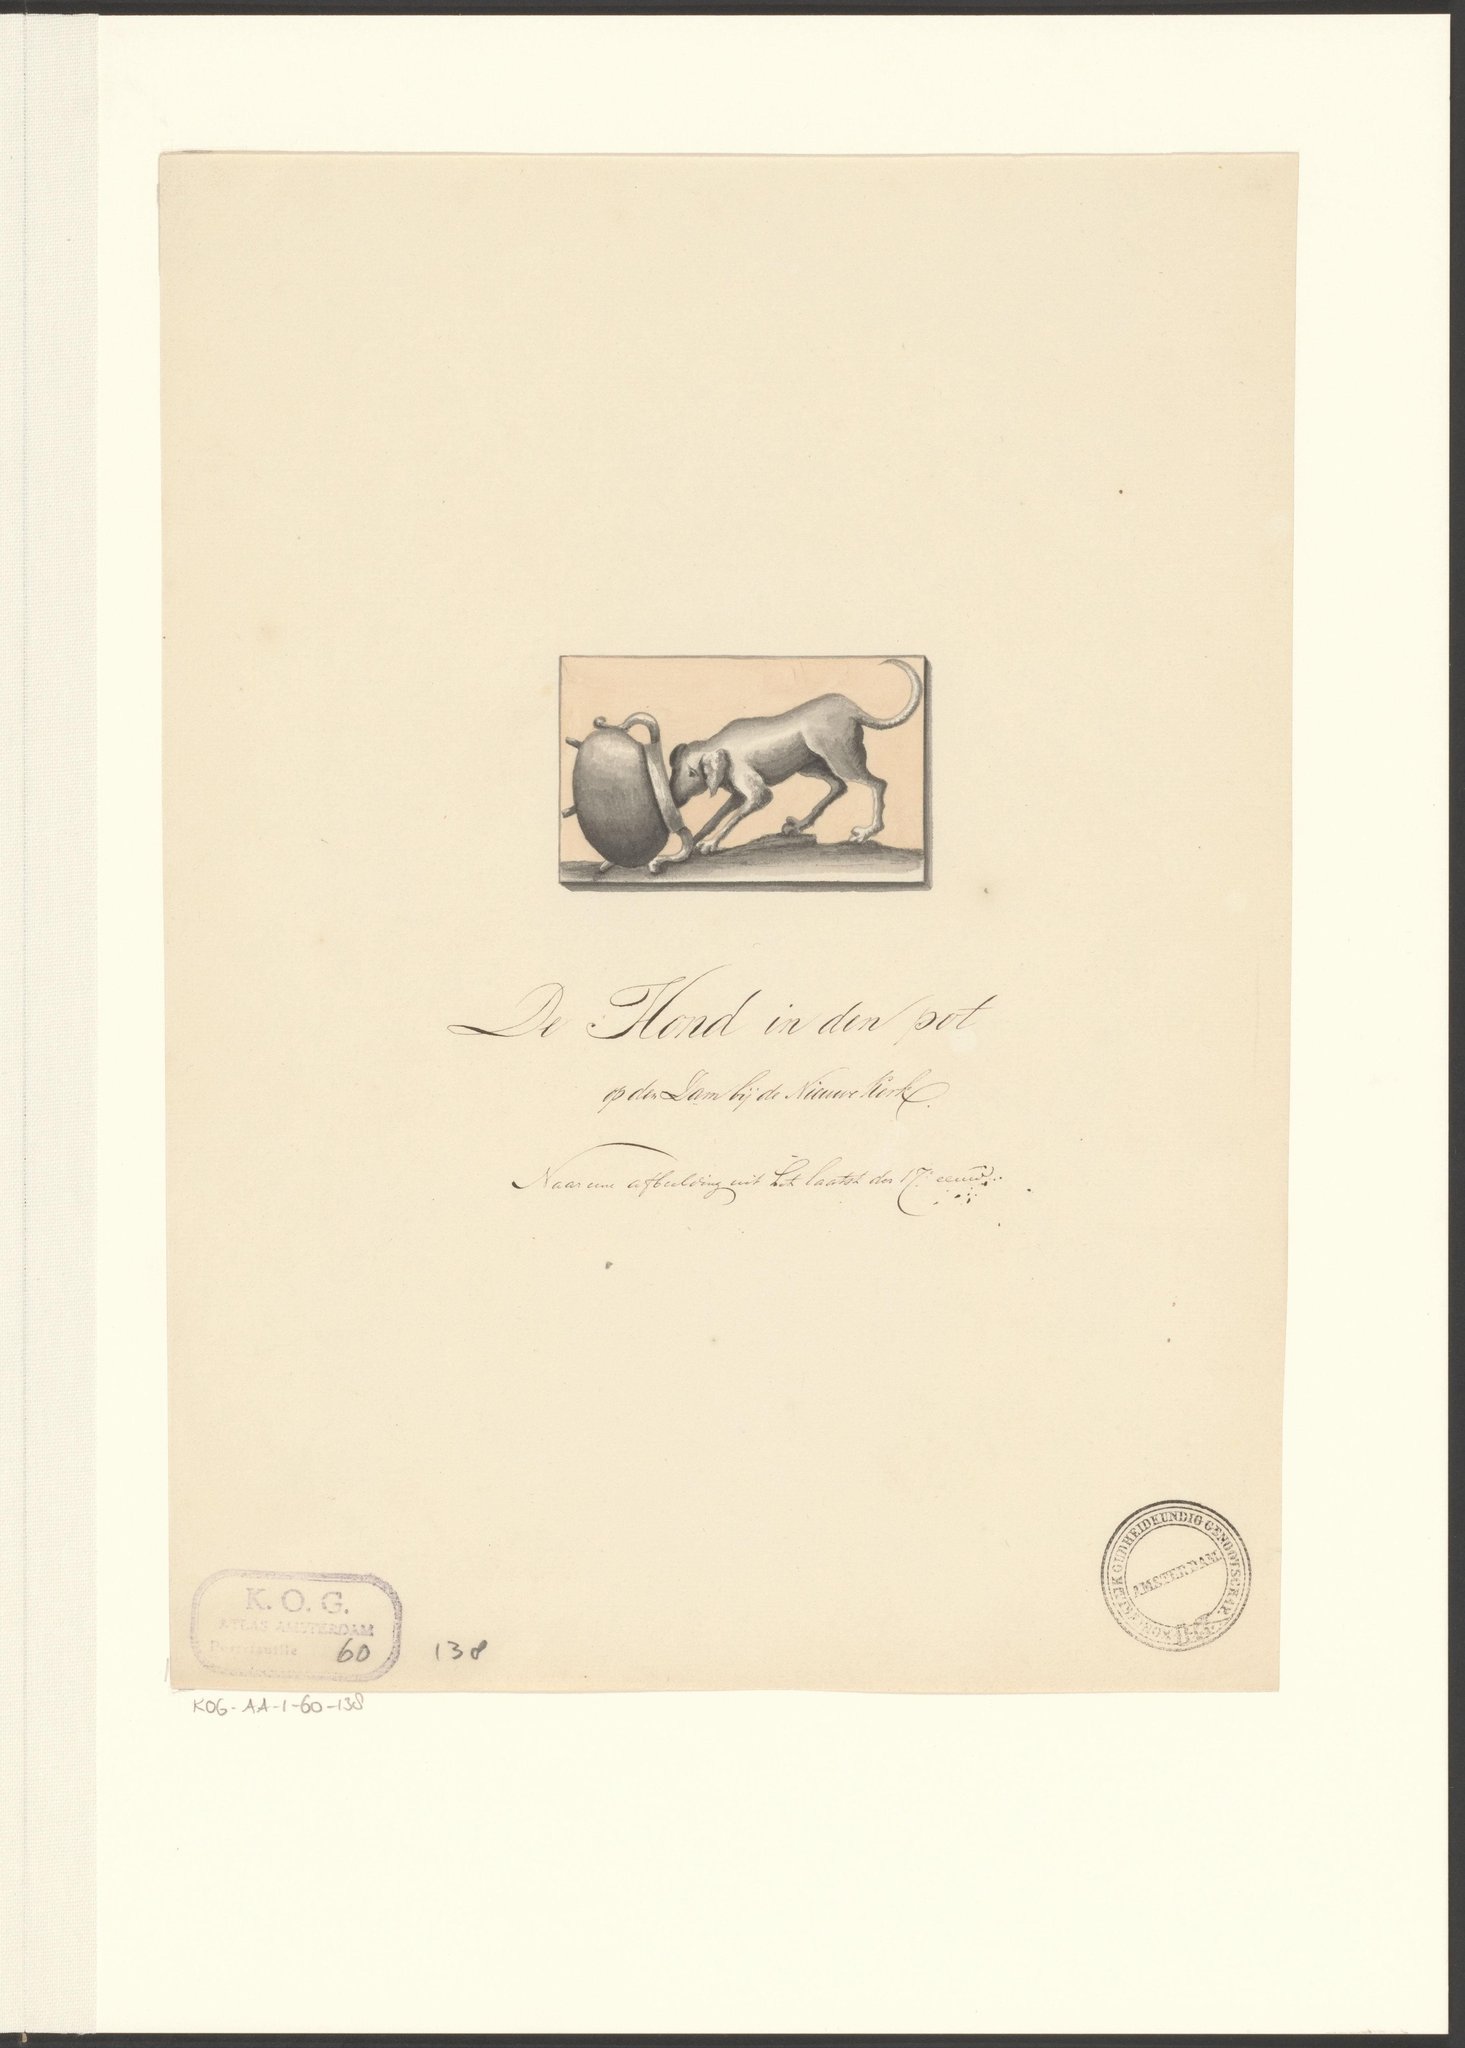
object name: drawing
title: Gevelsteen "De hond in den pot" op de Dam bij de Nieuwe Kerk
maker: jan ter gouw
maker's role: docent, schrijver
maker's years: 1814-1894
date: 1824-1894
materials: ink, paper, pencil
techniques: brush, pen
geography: amsterdam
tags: stone tablet in façade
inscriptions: stamp: ‘Koninklijk Oudheidkundig Genootschap / Amsterdam’, inscription: ‘De Hond in den pot / op den Dam bij de Nieuwe Kerk. / Naar een afbeelding uit het laatst den 17e eeuw.’, collector's mark: ‘60 138’ Lugt 1641b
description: Onderwerpsrubriek binnen de Atlas Amsterdam: Beeldhouwkunst - Gevelstenen.